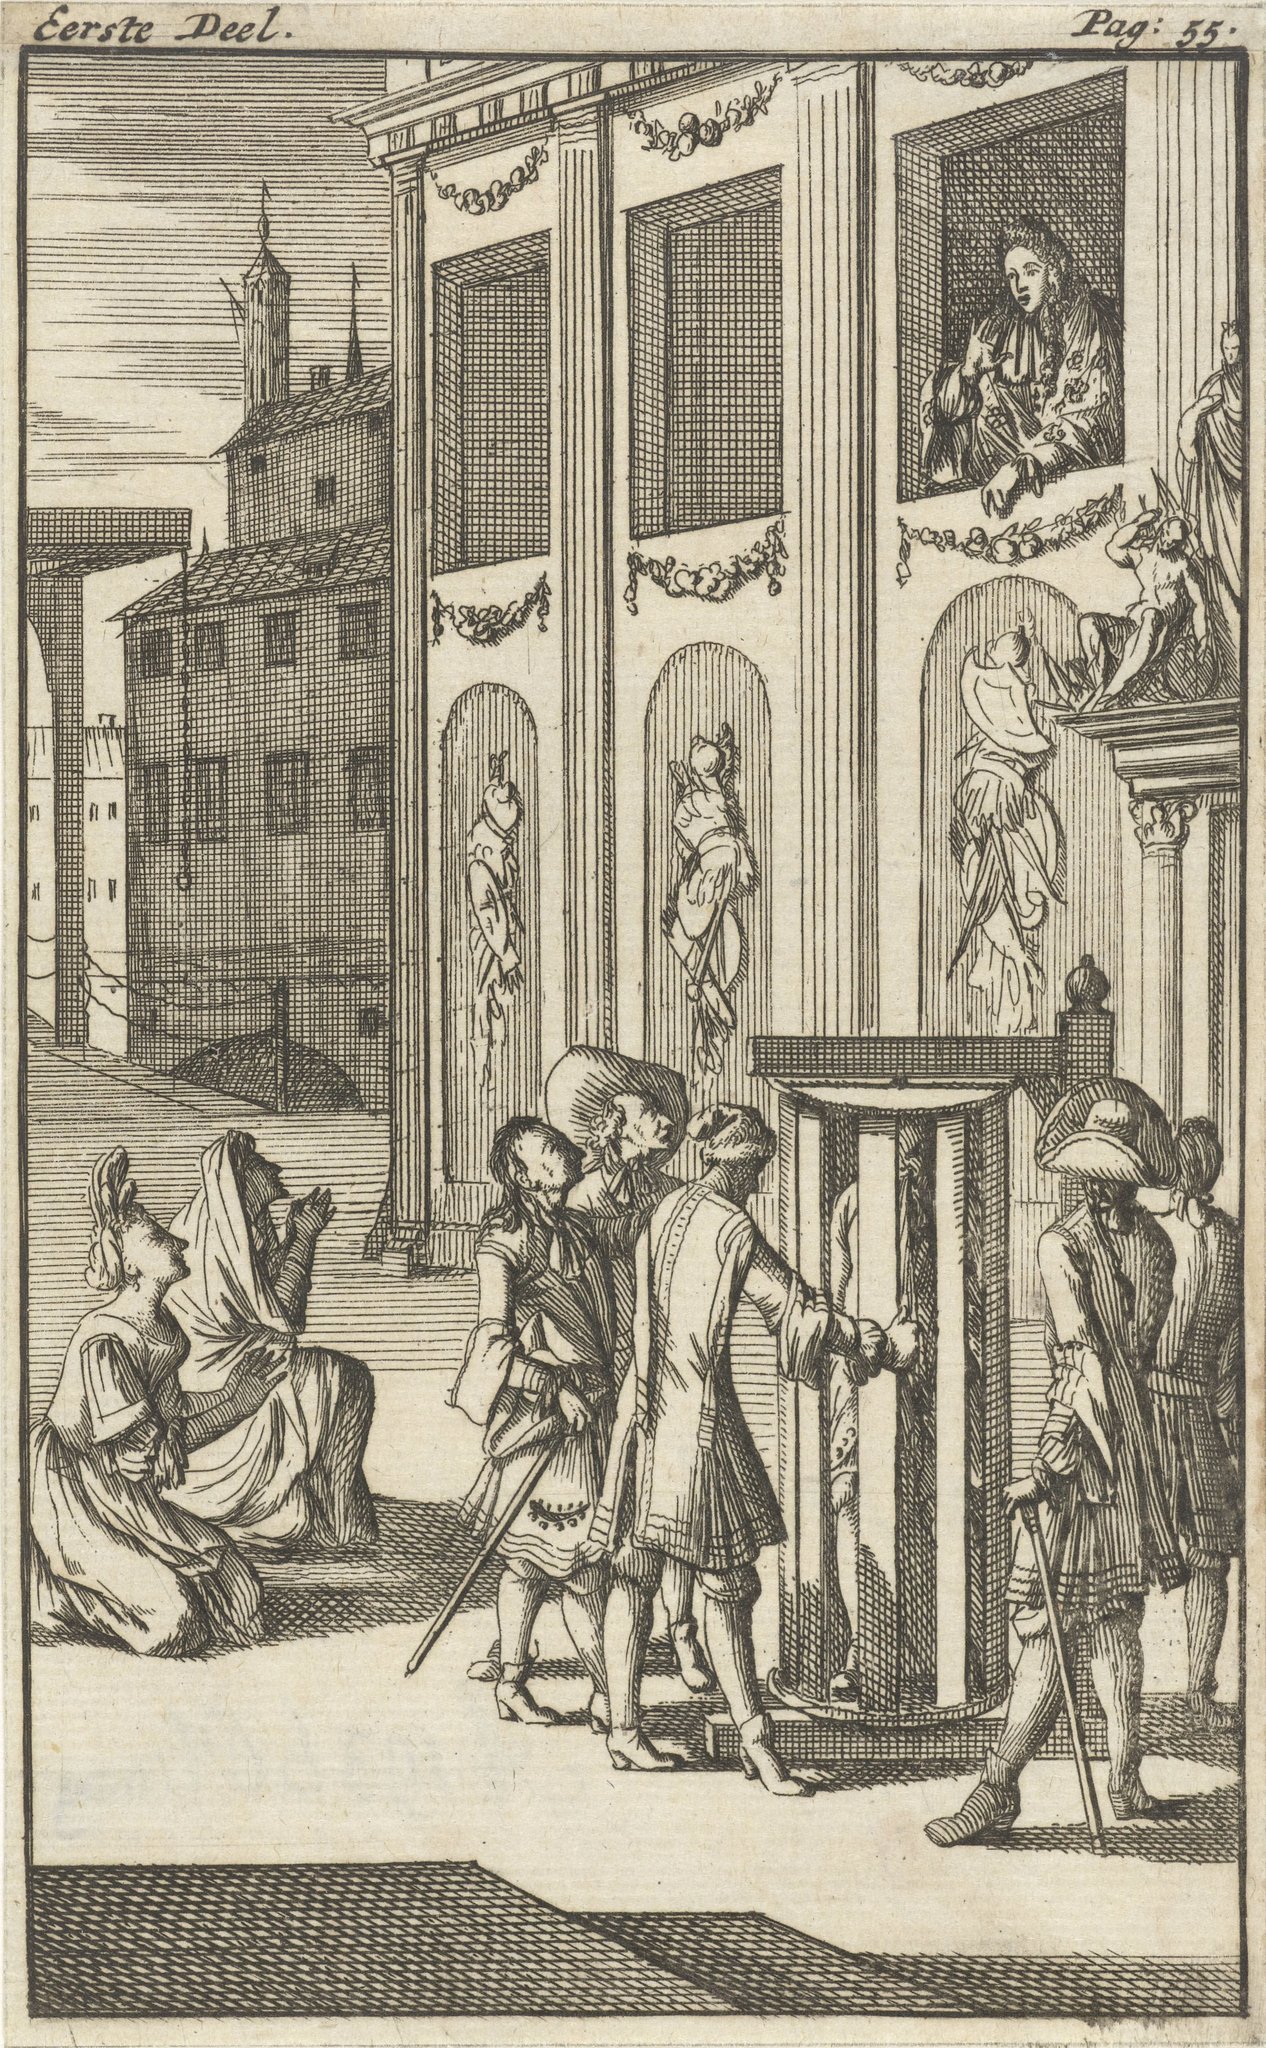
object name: book illustration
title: Mirandors meester, de herbergier, in de draaikooi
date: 1695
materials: paper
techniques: etching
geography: amsterdam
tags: imprisonment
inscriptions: collector's mark: Lugt 2228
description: Illustratie uit: Heinsius, Nicolaas jr. Den vermakelyken avanturier, ofte De wispelturige, en niet min wonderlyke levens-loop van Mirandor, 2 delen. Amsterdam: Pieter van Amsterdam, 1695, dl. I.